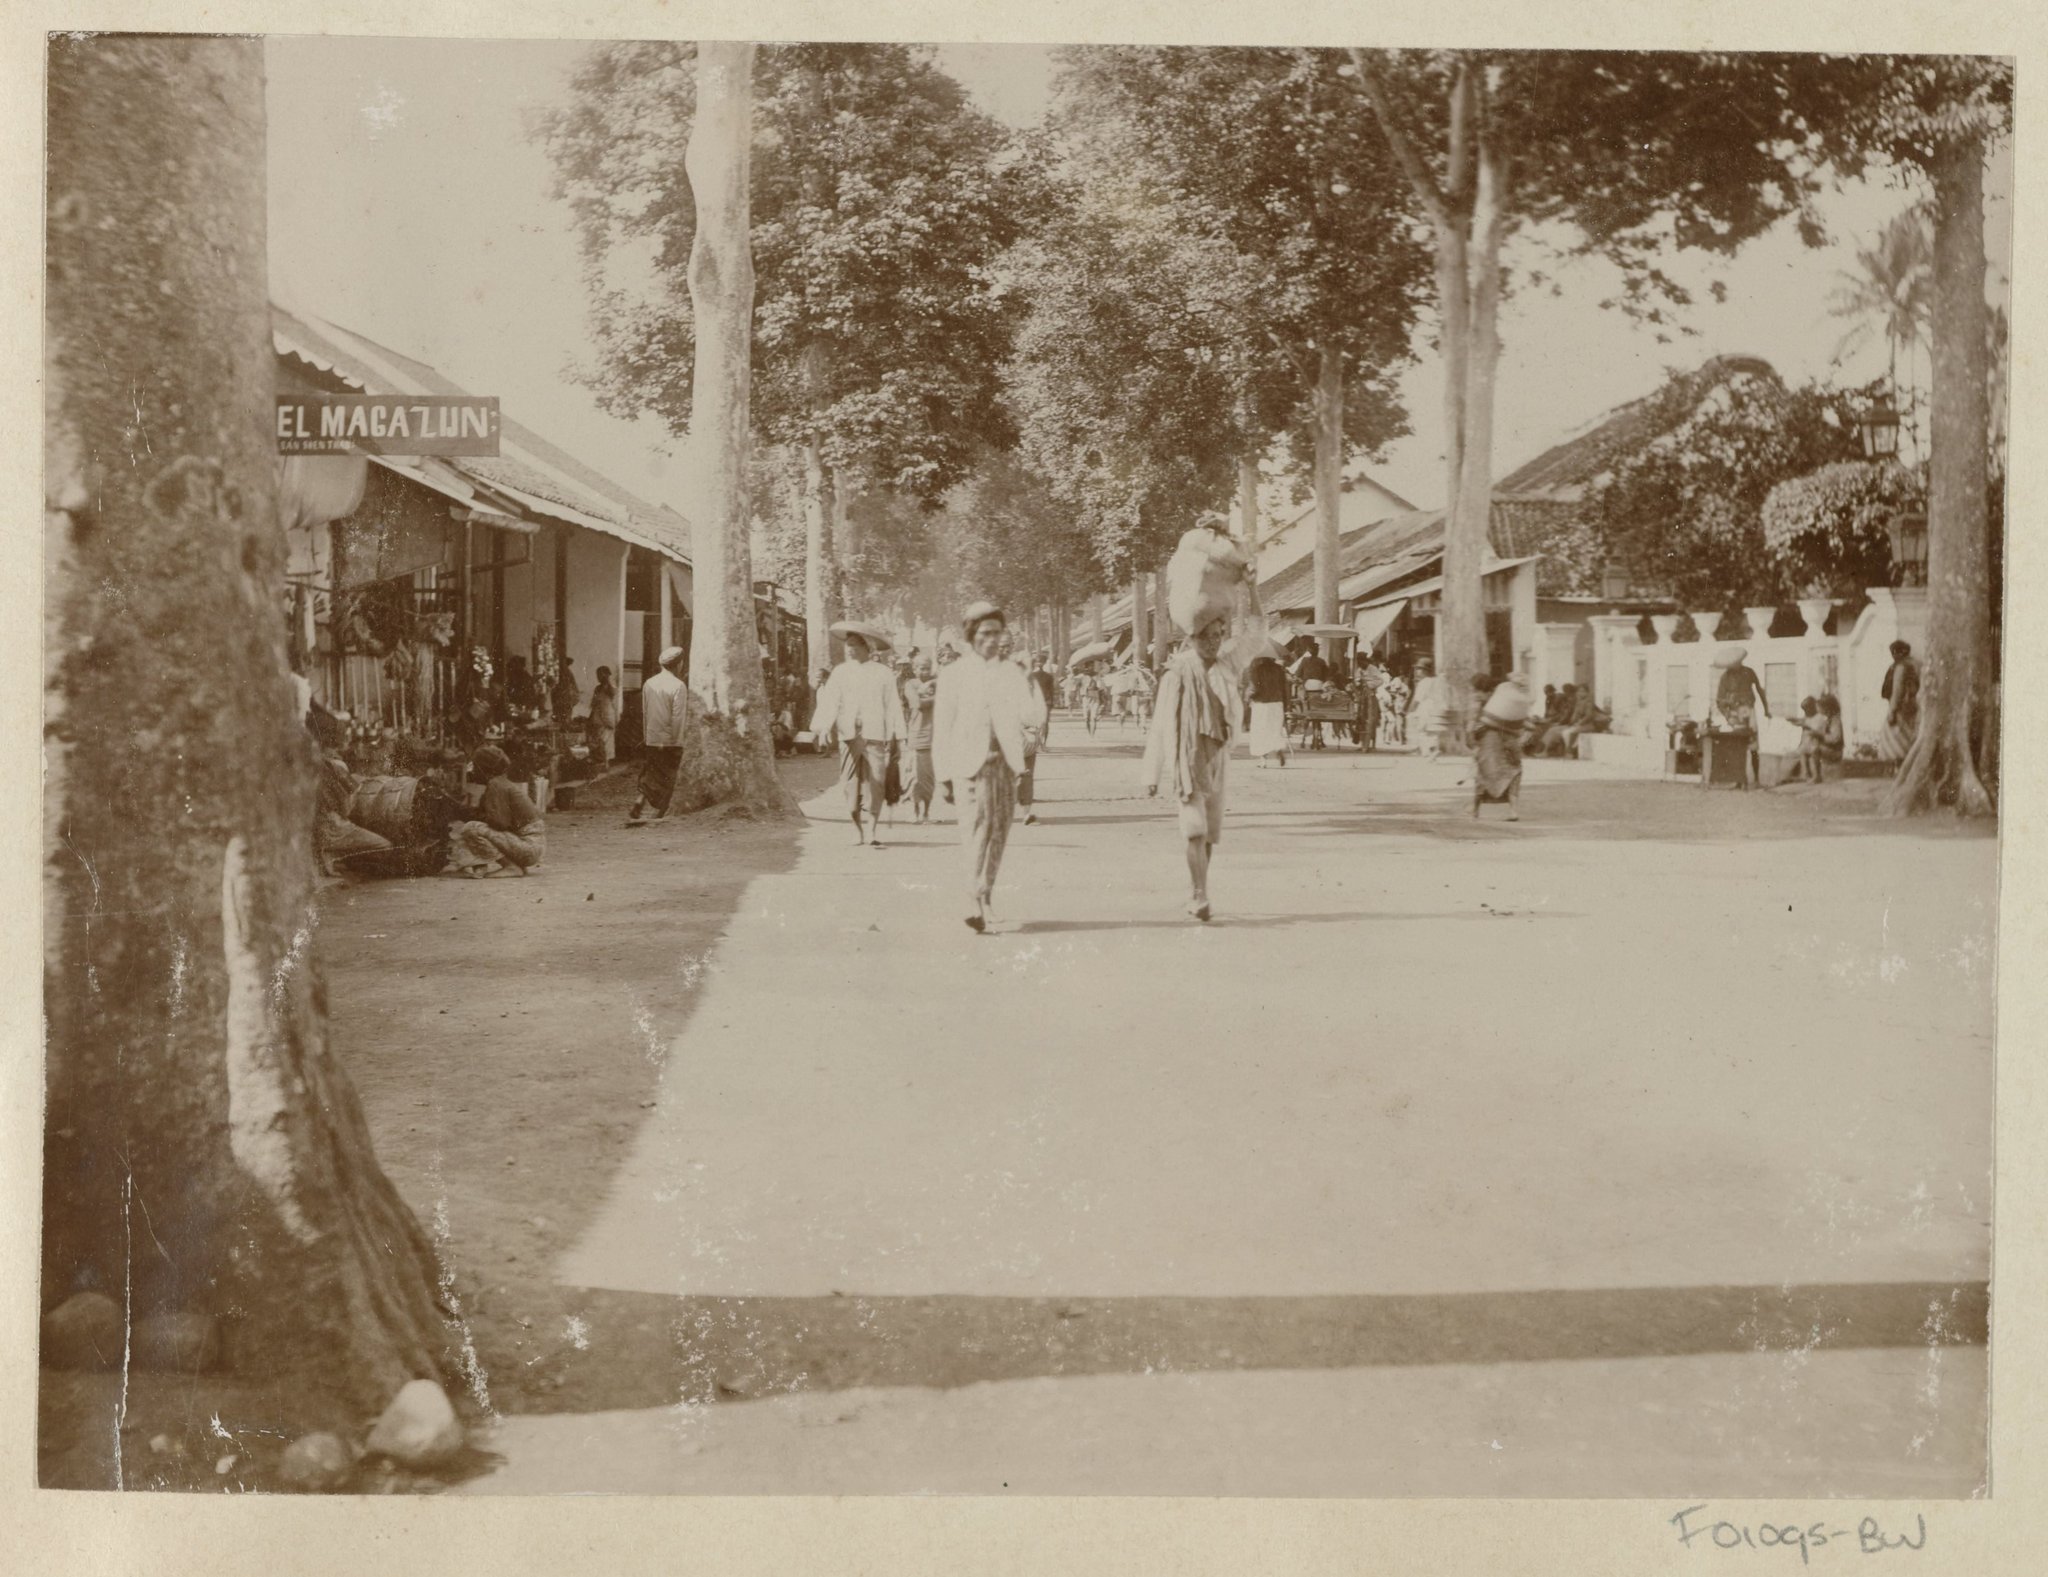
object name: photograph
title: Straatbeeld in Nederlands-Indië met voorbijgangers en winkels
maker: Anonymous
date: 1895-1905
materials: paper, photographic support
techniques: collodion silver print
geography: dutch east indies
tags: shop, store, street, dutch east indies, the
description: Onderdeel van Reisalbum met foto's van bezienswaardigheden in Italië, Zwitserland en Nederlands-Indië.